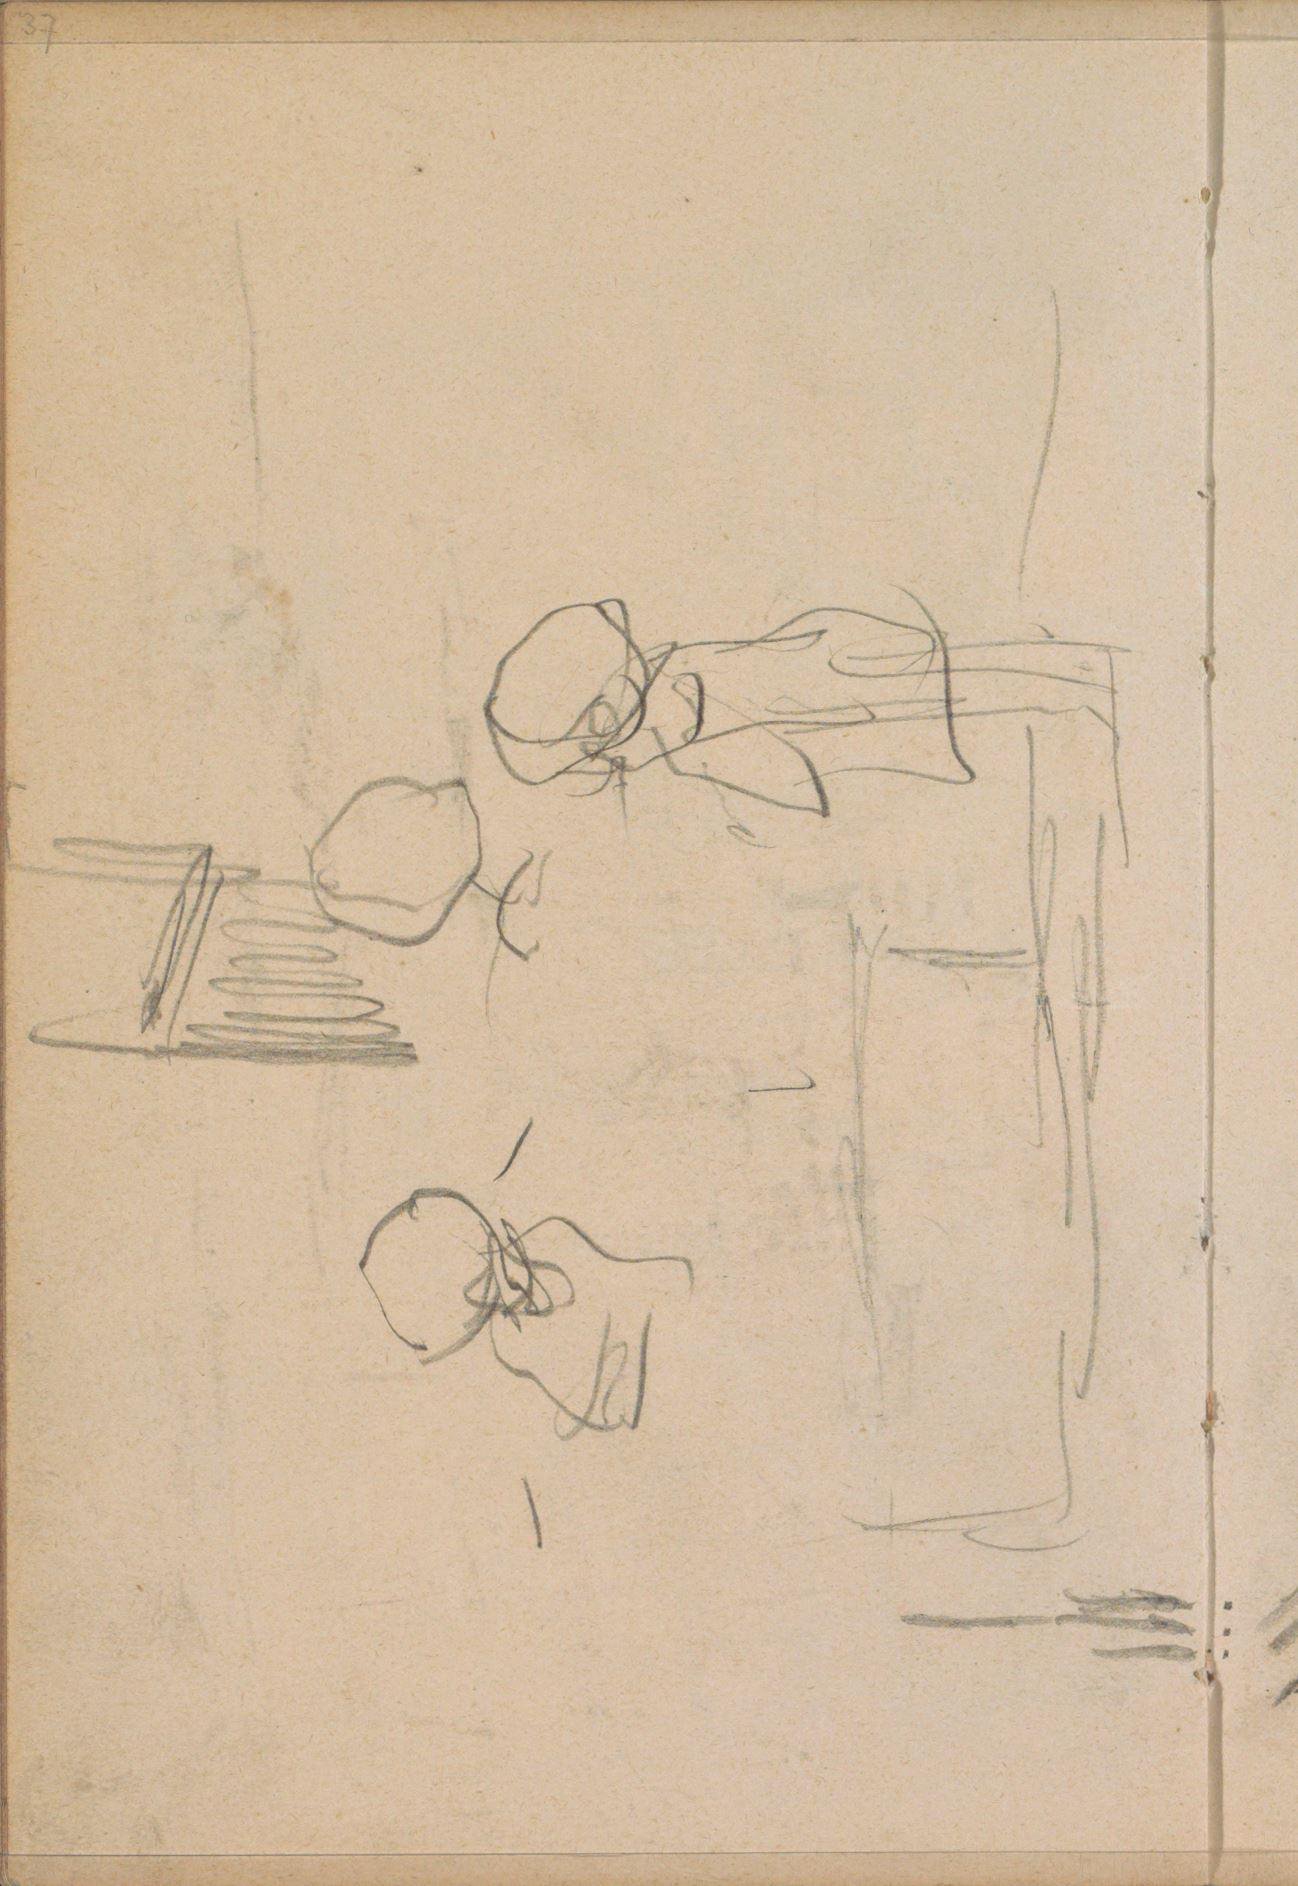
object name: sketchbook leaf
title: Drie kinderen bij een orgel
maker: george hendrik breitner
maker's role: draughtsman, painter, print maker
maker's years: 1857-1923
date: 1902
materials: paper, pencil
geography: amsterdam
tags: organ - cc - out of doors, child (+ three persons)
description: Pagina 37 uit een schetsboek met 46 bladen vervaardigd in de omgeving van Amsterdam, Rotterdam en Haarlem.